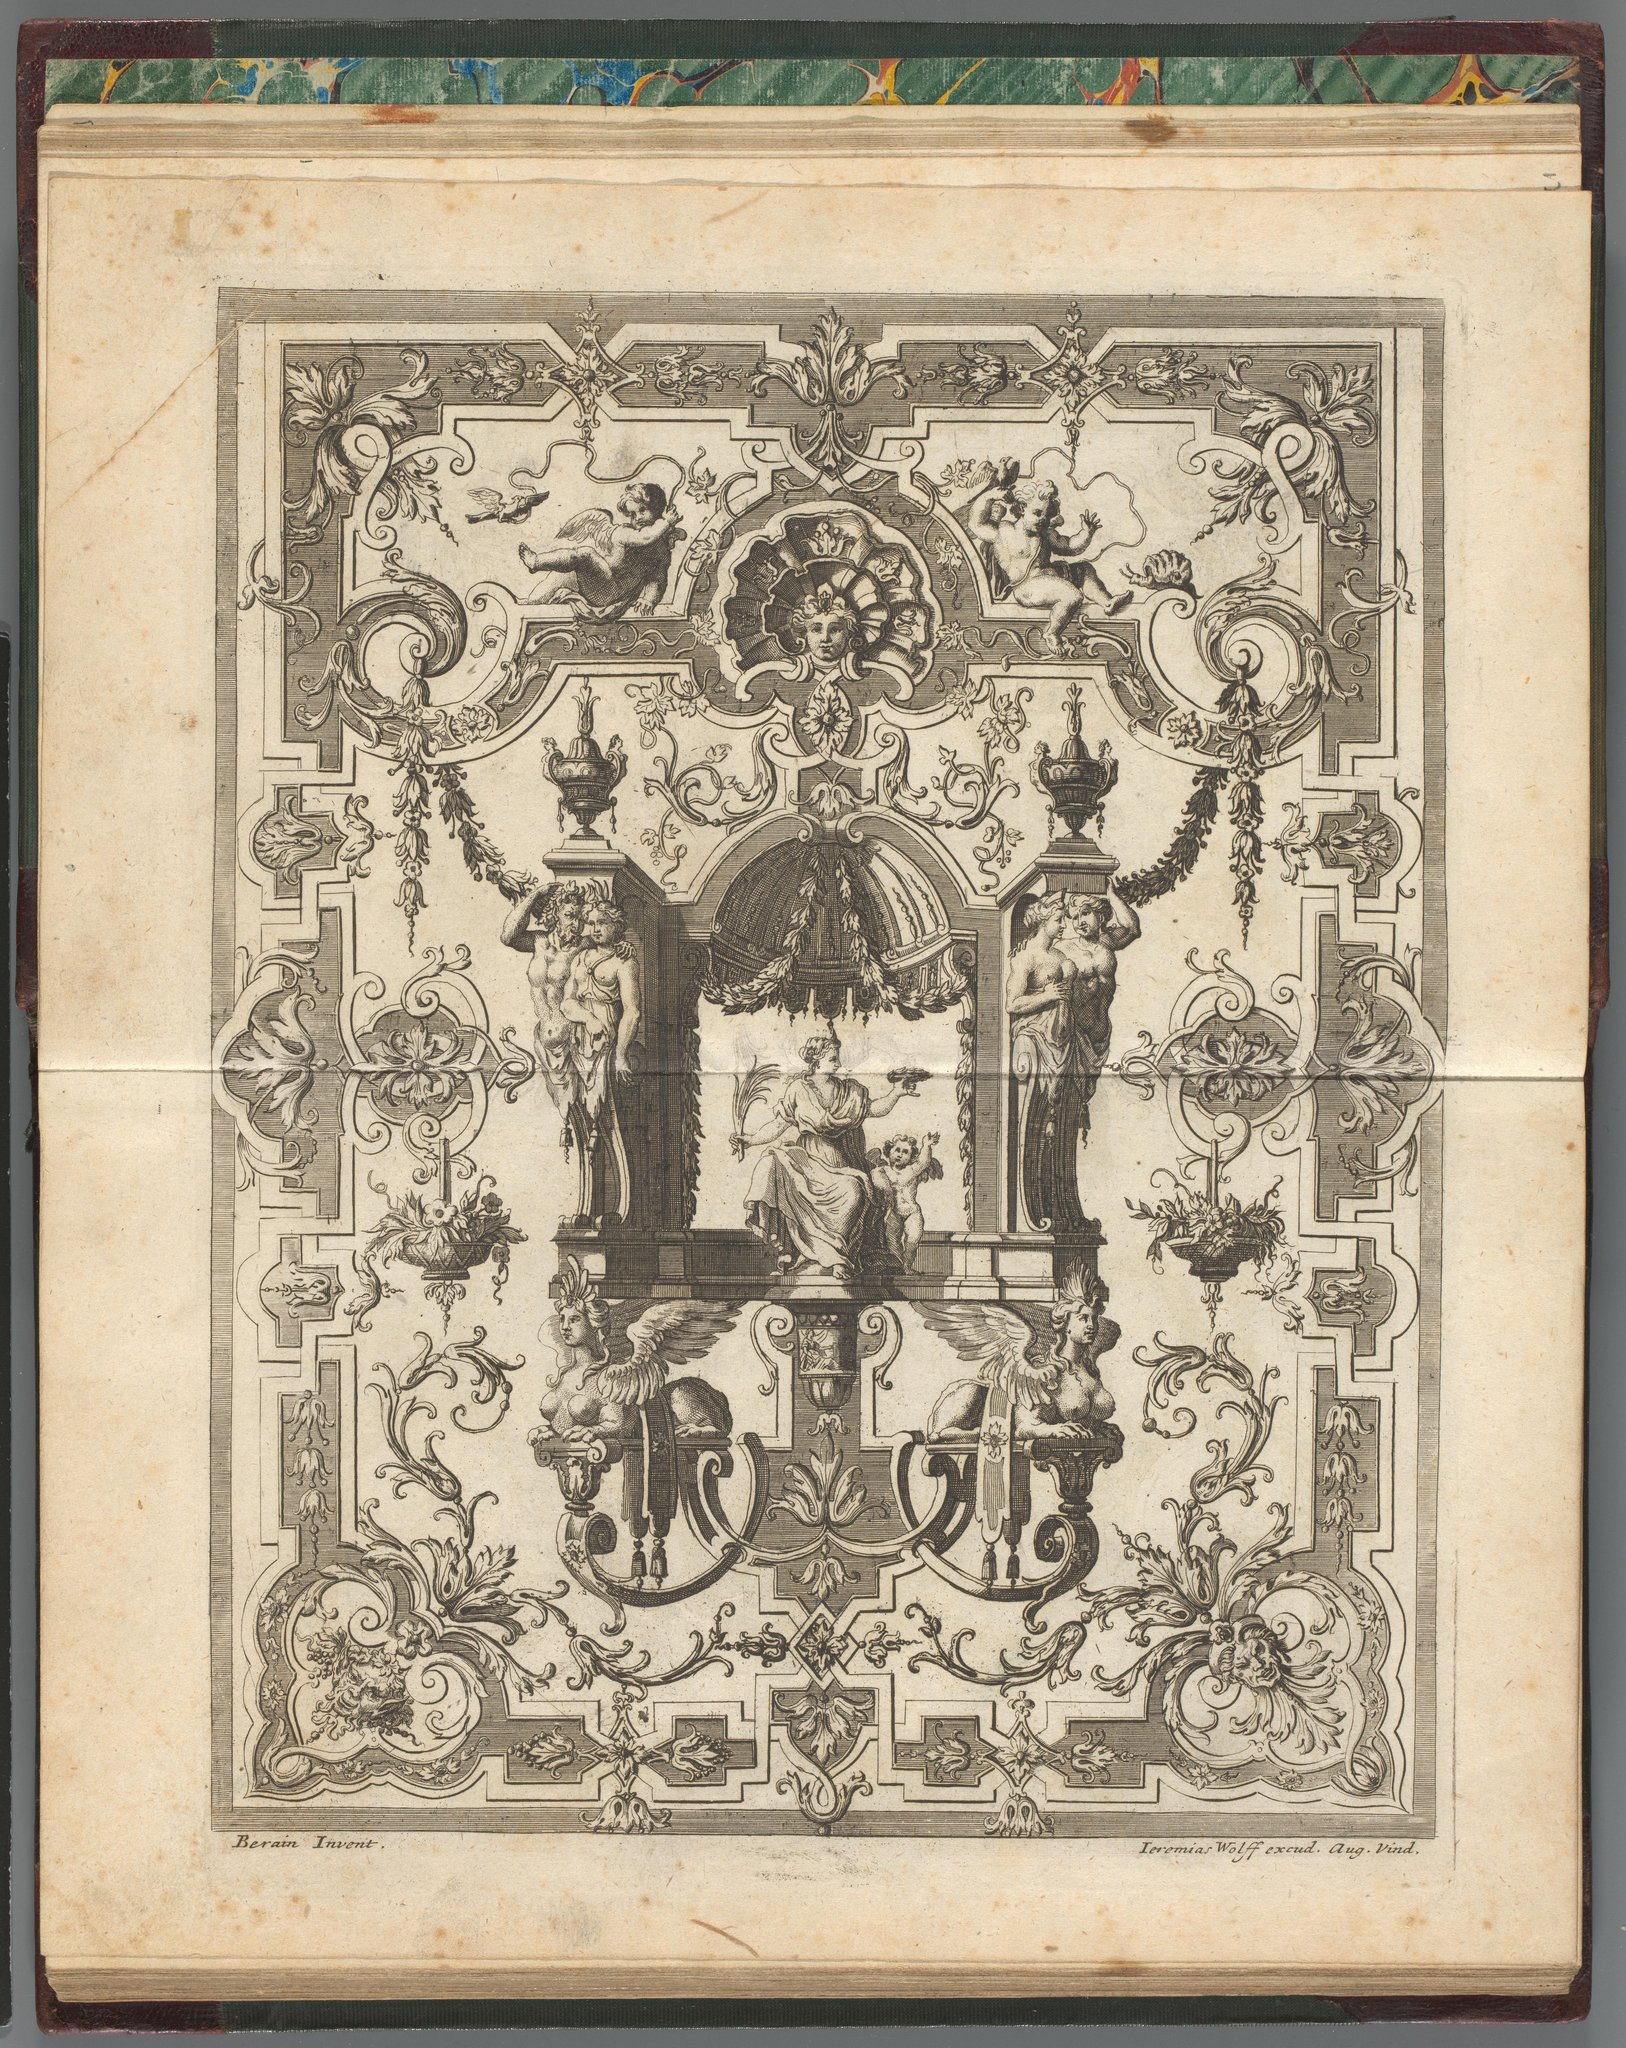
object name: print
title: Compositie met Nike en putto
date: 1686-1724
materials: paper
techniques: etching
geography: augsburg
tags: ornaments ~ art, atlantes ~ architecture, sphinx (lion/woman); 'sfinge' (ripa), caryatids ~ architecture, mask, mascaron ~ ornament, (story of) nike, ornament ~ festoon, garland, cupids: 'amores', 'amoretti', 'putti'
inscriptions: signature: ‘Ieremias Wolff excud. Aug. Vind.’, signature: ‘Berain Invent.’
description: Een decoratieve compositie met vlechtwerk en in het midden Nike zittend met een palmtak in haar rechterhand en een lauwerkrans in haar linkerhand die ze boven een putto houdt. Ze zitten in een nis omhoog gehouden door twee twee sfinxen en atlanten en kariatiden. Het geheel is omringd met festoenen, putti, maskers en dieren. Prent maakt deel uit van een album. Hoogstwaarschijnlijk gespiegelde kopie naar Frans origineel.